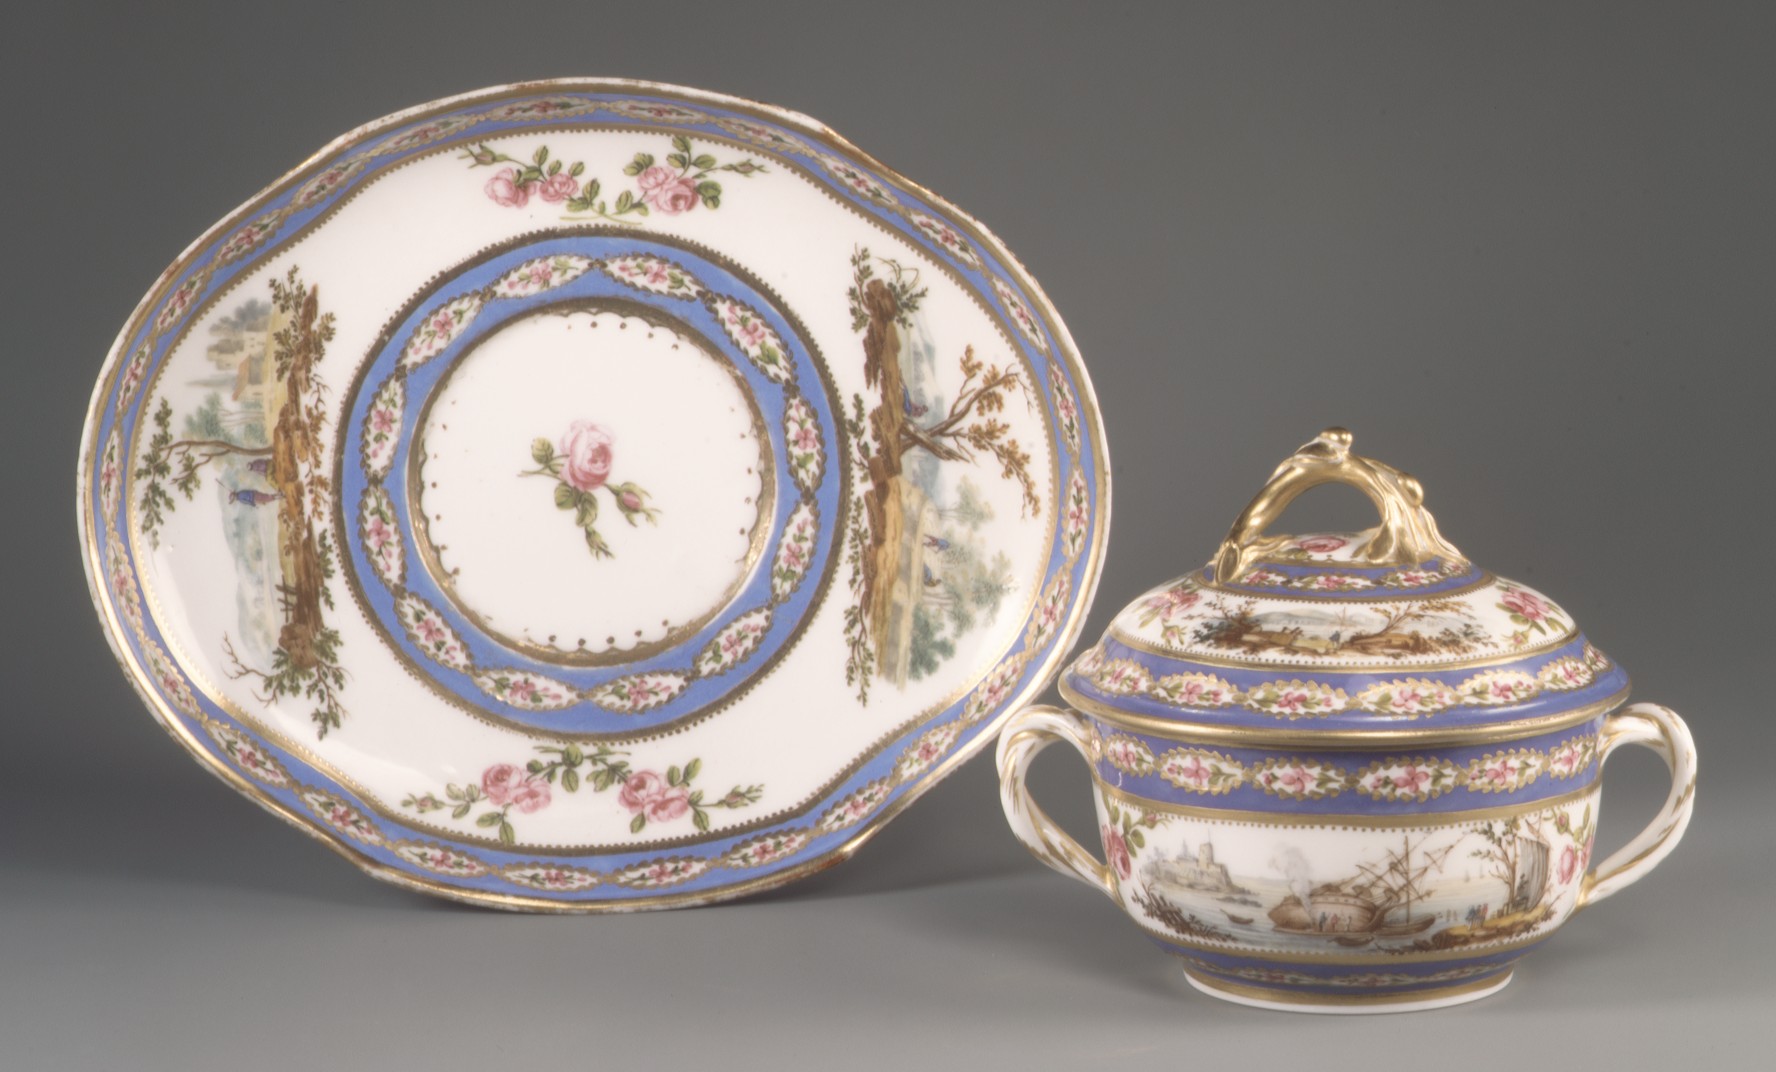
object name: bowl with cover and tray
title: Bowl with cover (écuelle) and tray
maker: sèvres manufactory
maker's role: manufactory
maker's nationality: french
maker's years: 1740-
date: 1784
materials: soft paste porcelain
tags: men,flowers,ships